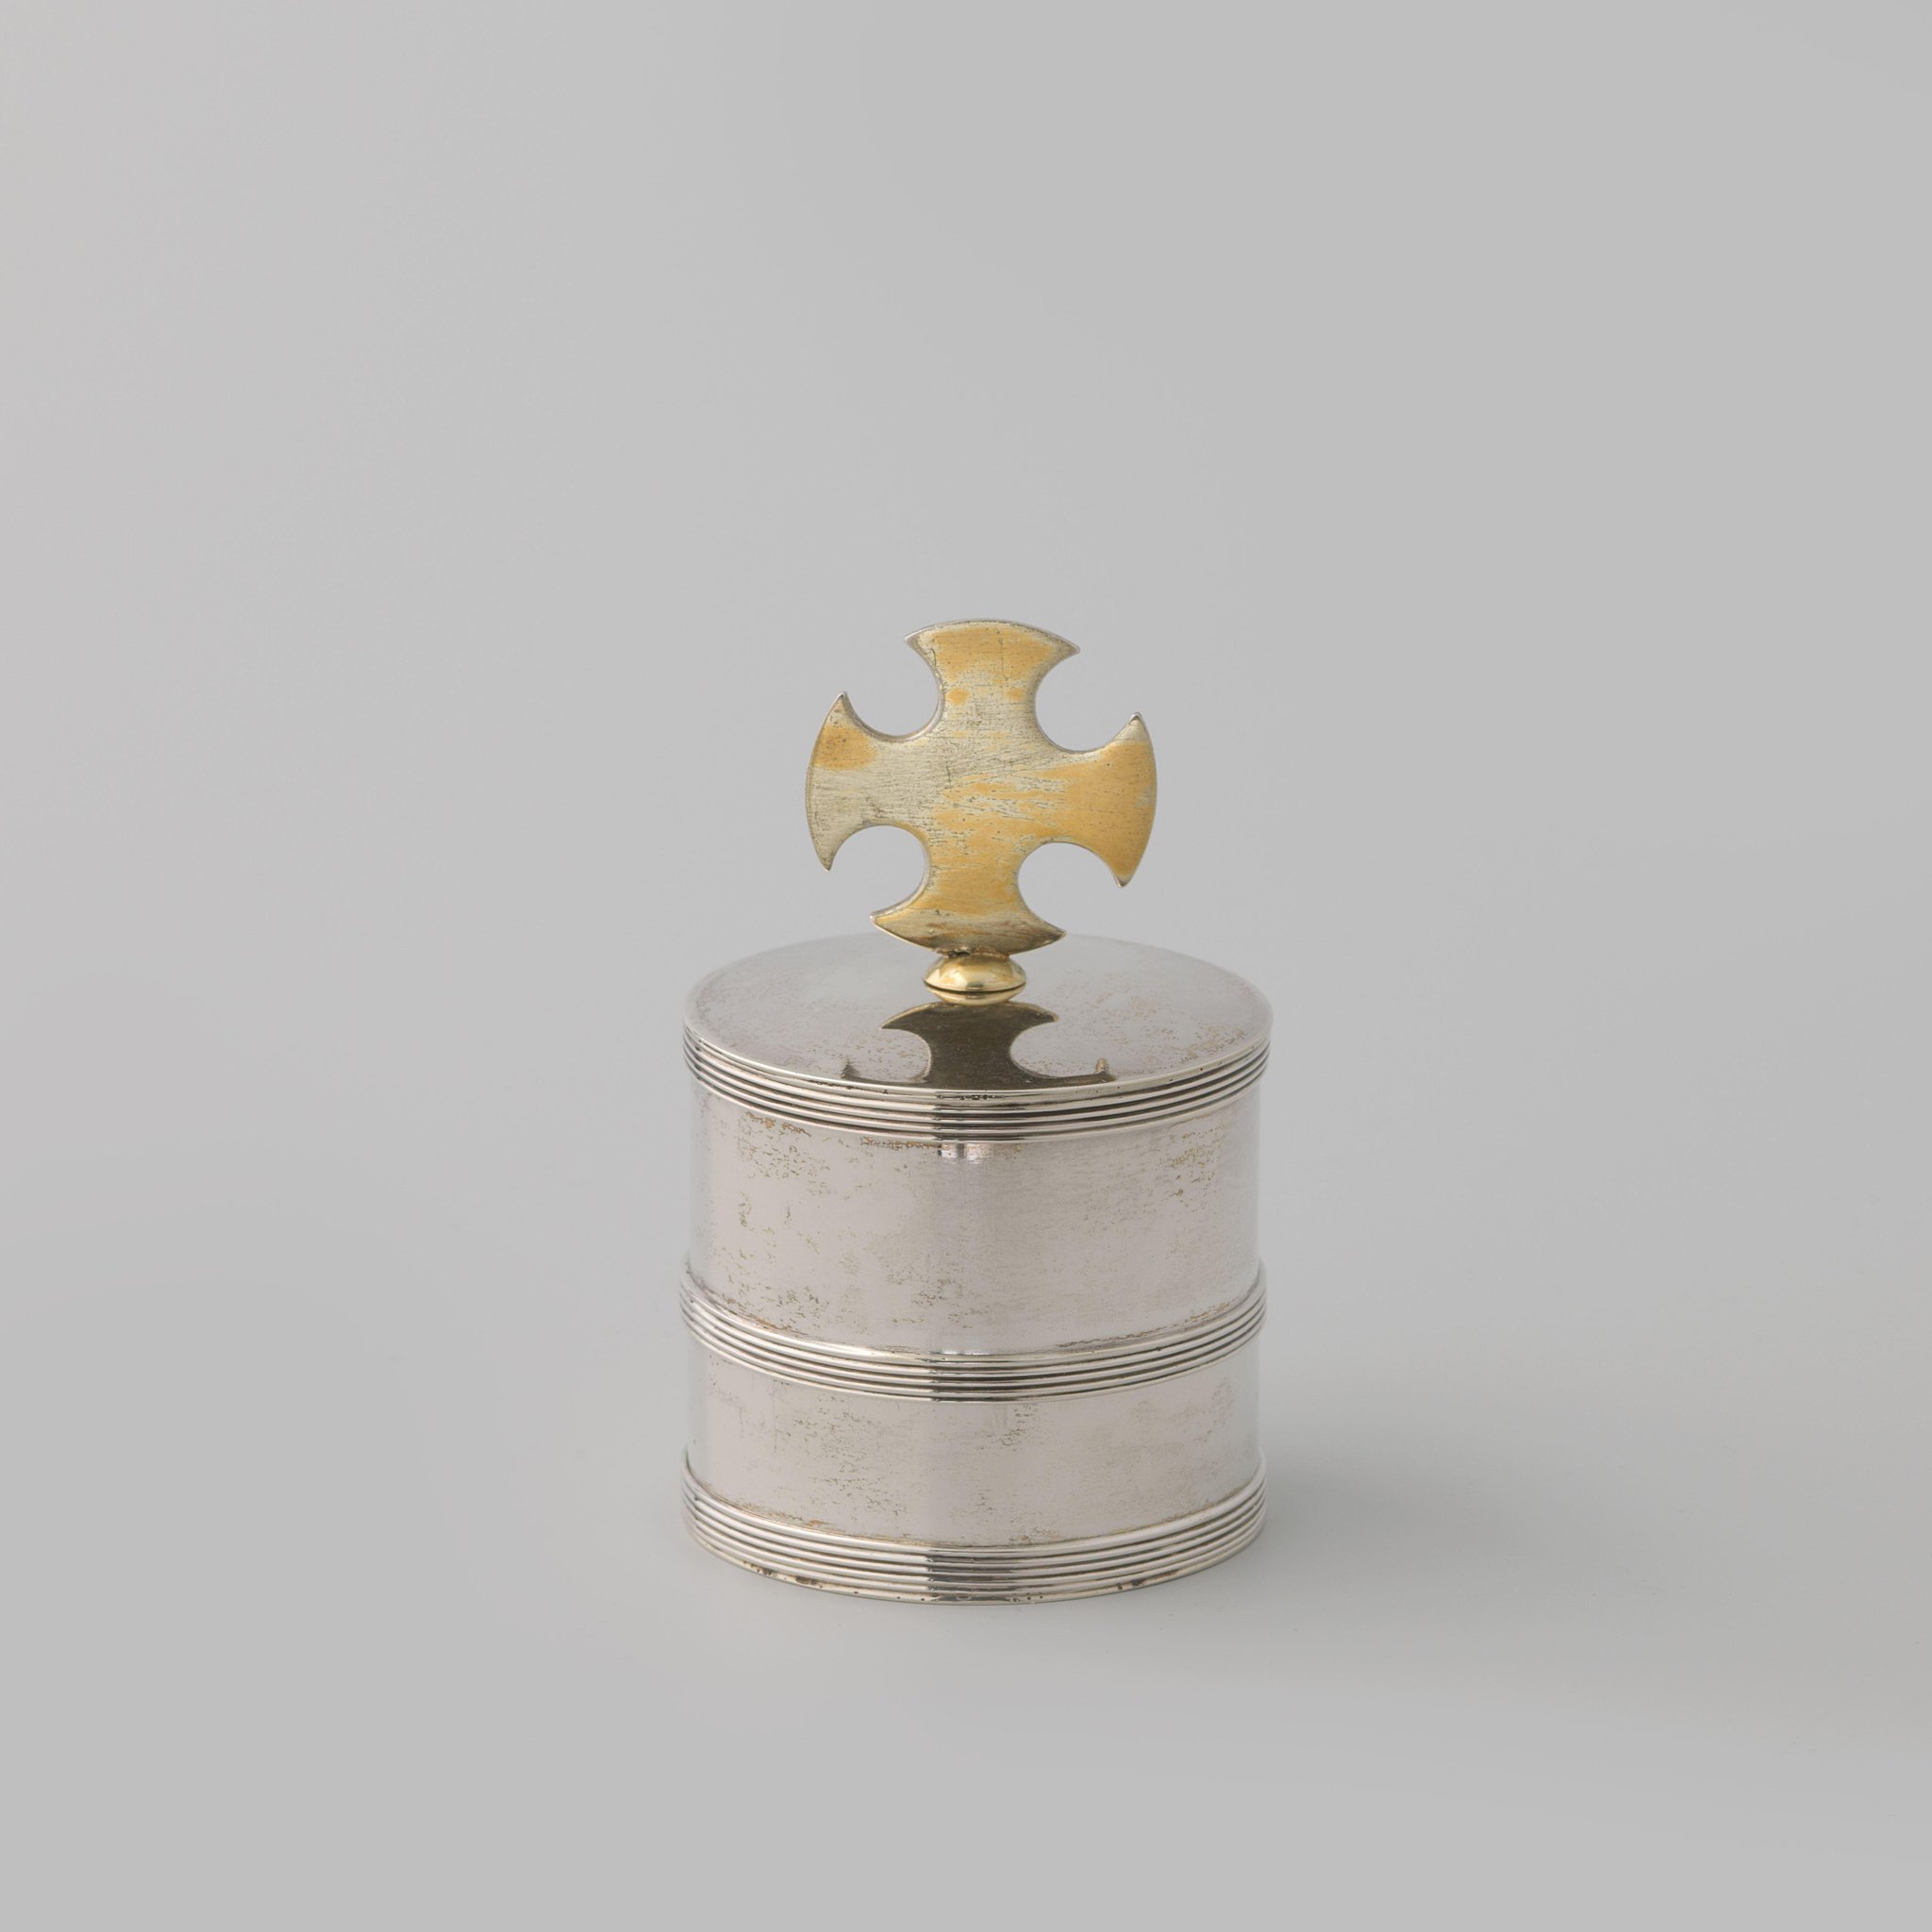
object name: box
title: Bedieningsdoos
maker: a.j. hombergen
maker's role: silversmith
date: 1845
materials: silver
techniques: gilding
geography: breda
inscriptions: mark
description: Sacrament box. Silver. Breda, 1845, by A.J. Hombergen. Given by Mr and Mrs Jaffé-Pierson, 1978.